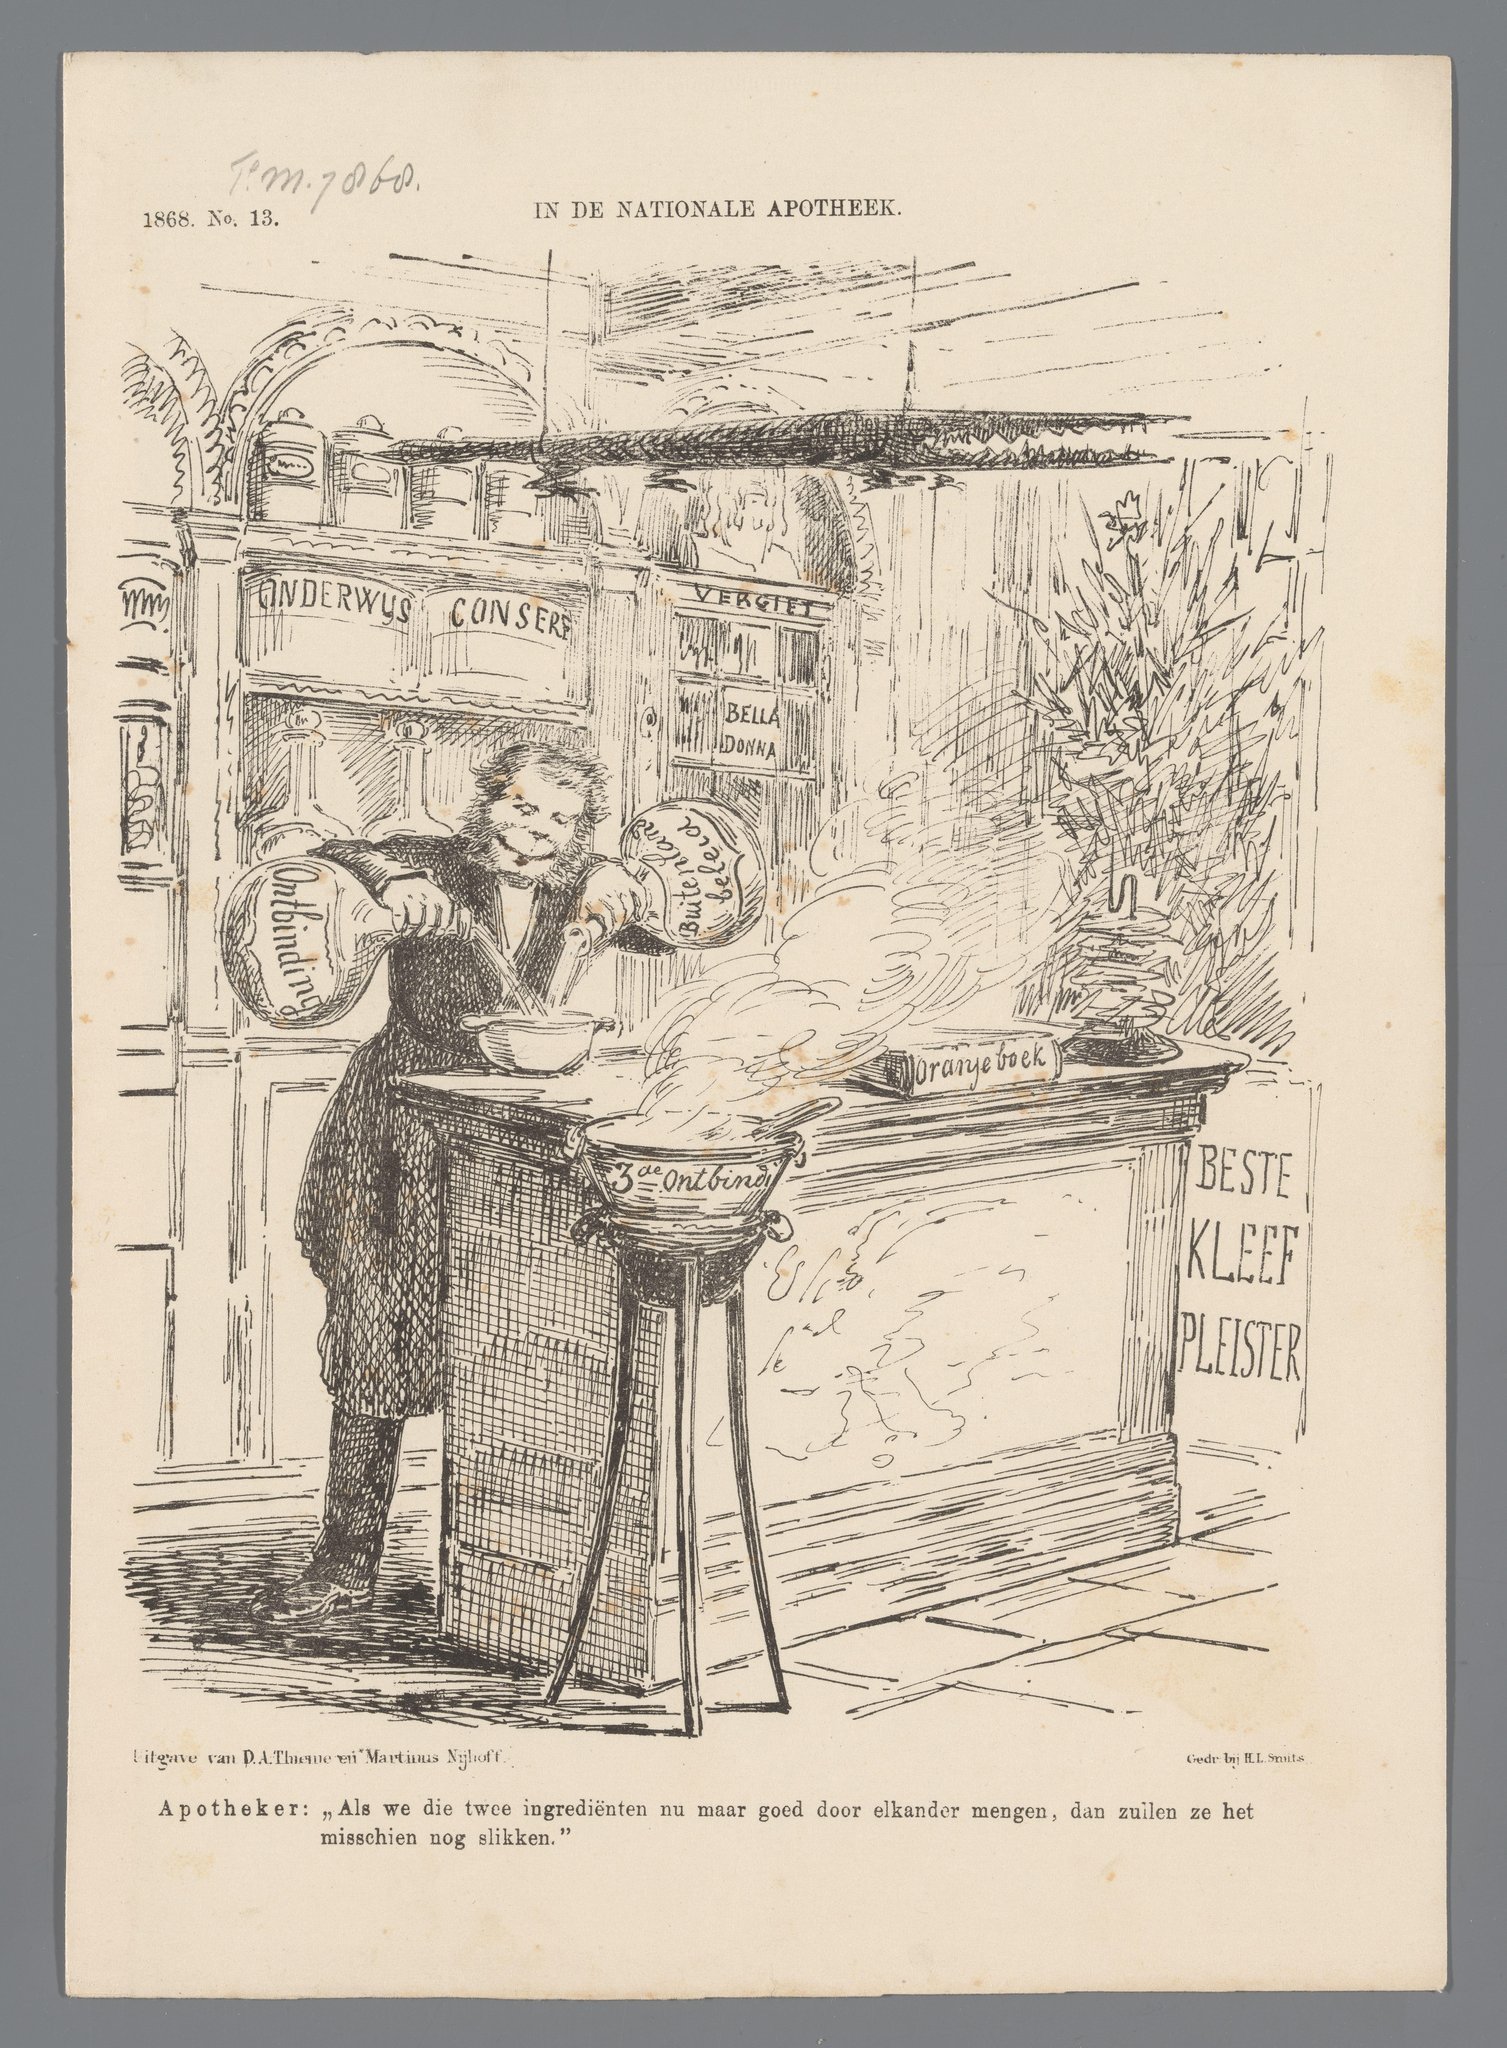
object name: print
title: In de Nationale Apotheek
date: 1867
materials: paper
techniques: lithograph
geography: netherlands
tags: earl, pharmacist, druggist, apothecary; pharmacy, drugstore, dispensing chemist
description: Spotprent op minister Van Zuylen die als apotheker verschillende stoffen bij elkaar giet. Plaat verschenen bij het weekblad De Nederlandsche Spectator, nr. 12, 21 maart 1868.